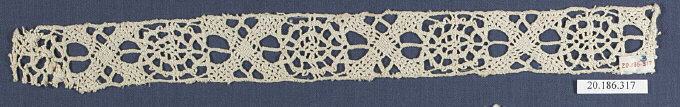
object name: insertion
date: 1601-1700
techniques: lace